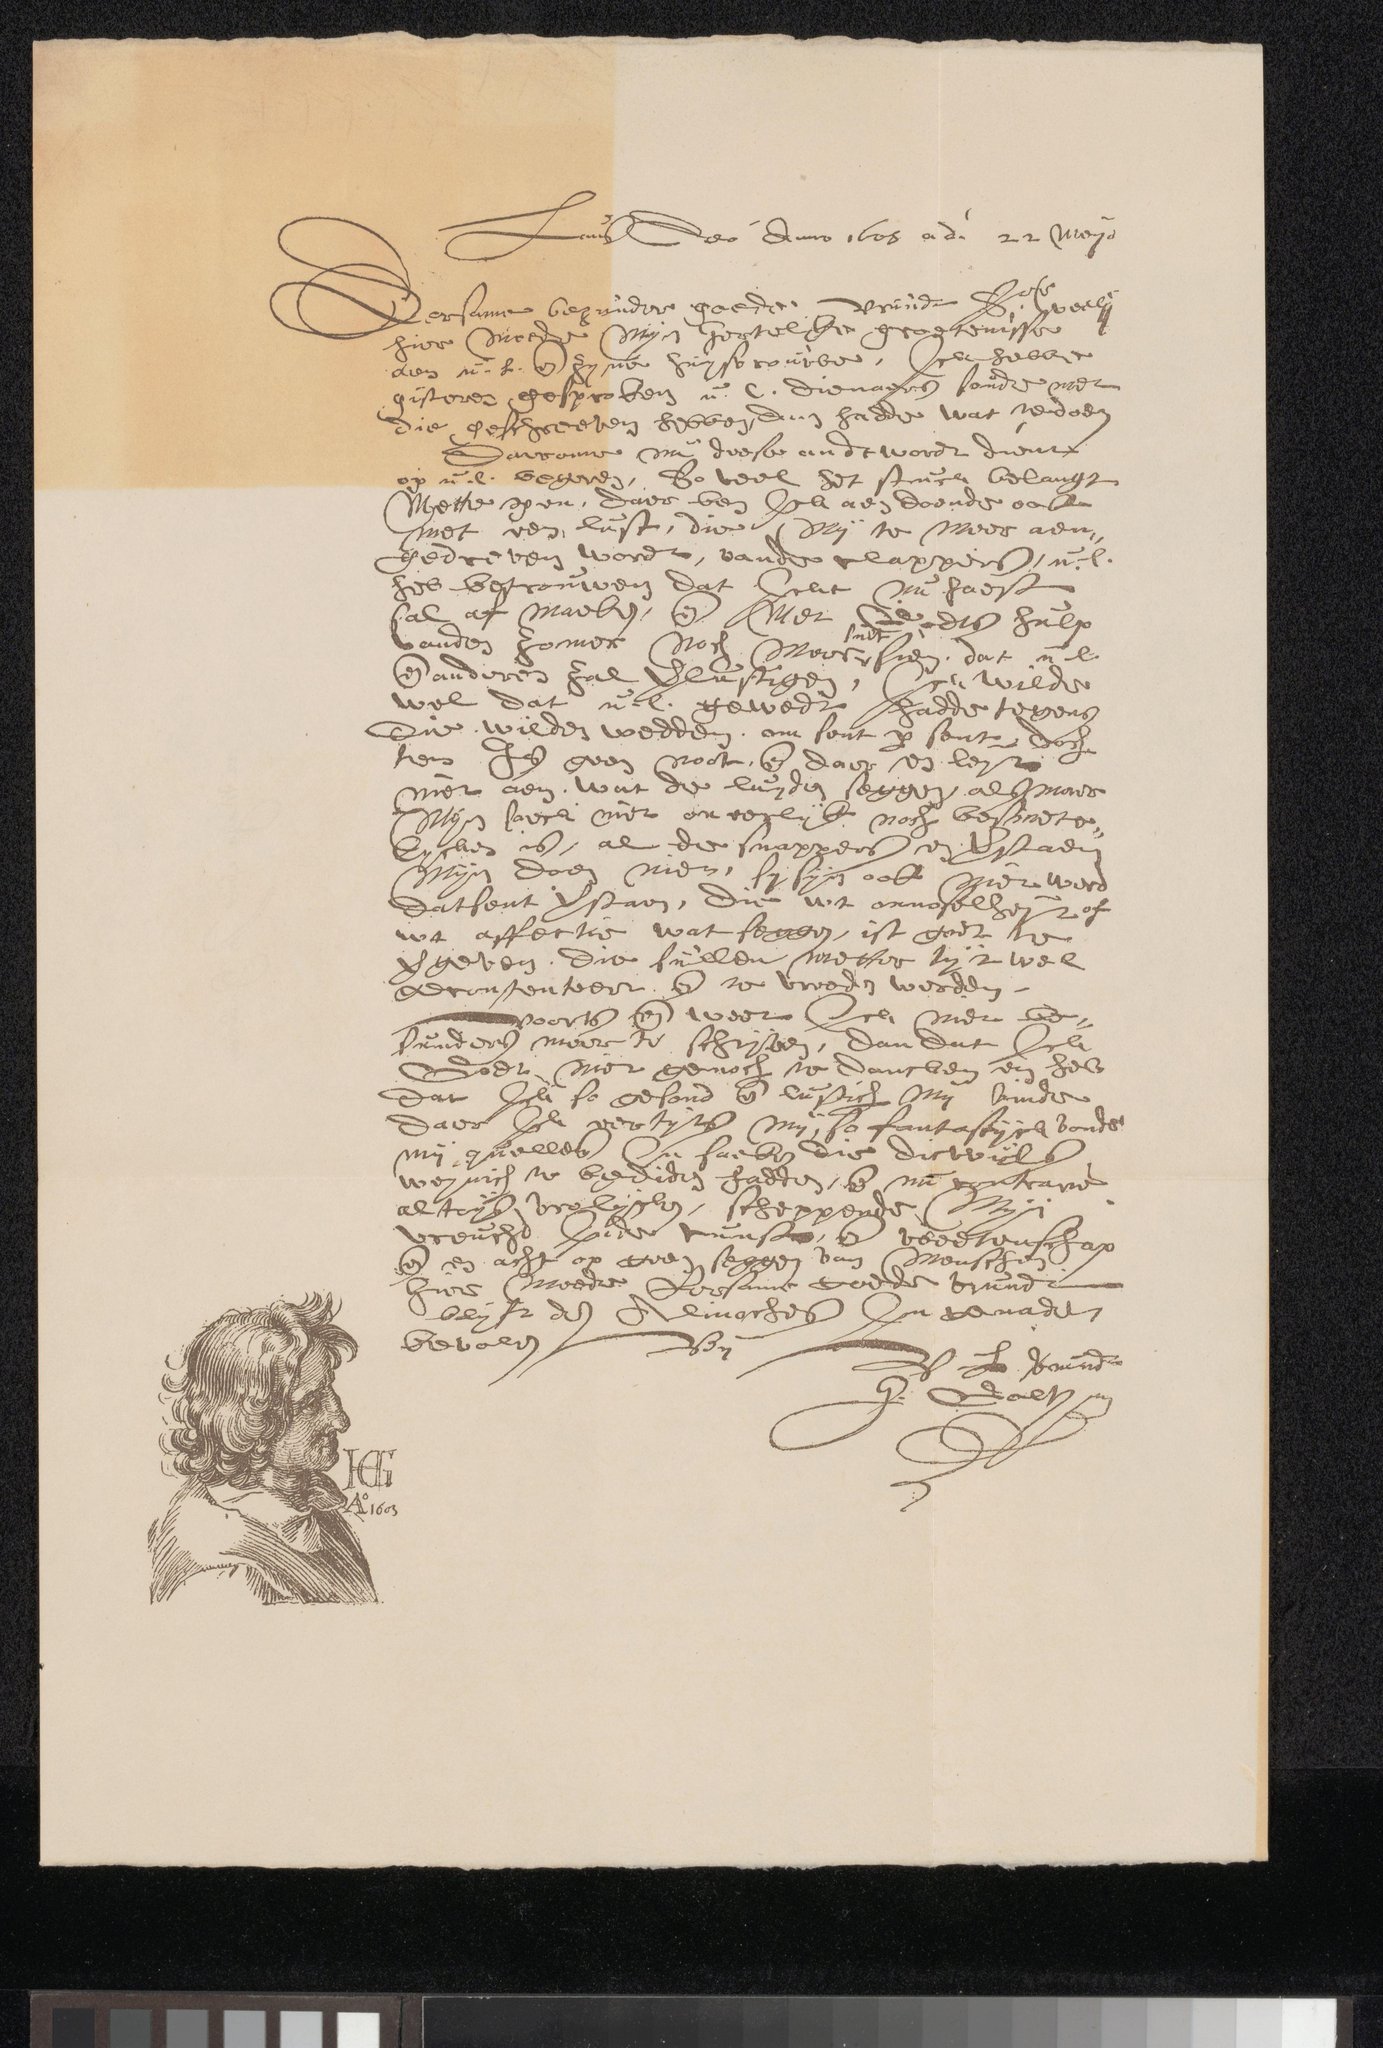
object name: letter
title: Facsimile van een brief aan Jan van Wely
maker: Anonymous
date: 1605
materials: paper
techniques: printing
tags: drawing, passions, emotions, affections, adult man (+ sideview, profile)